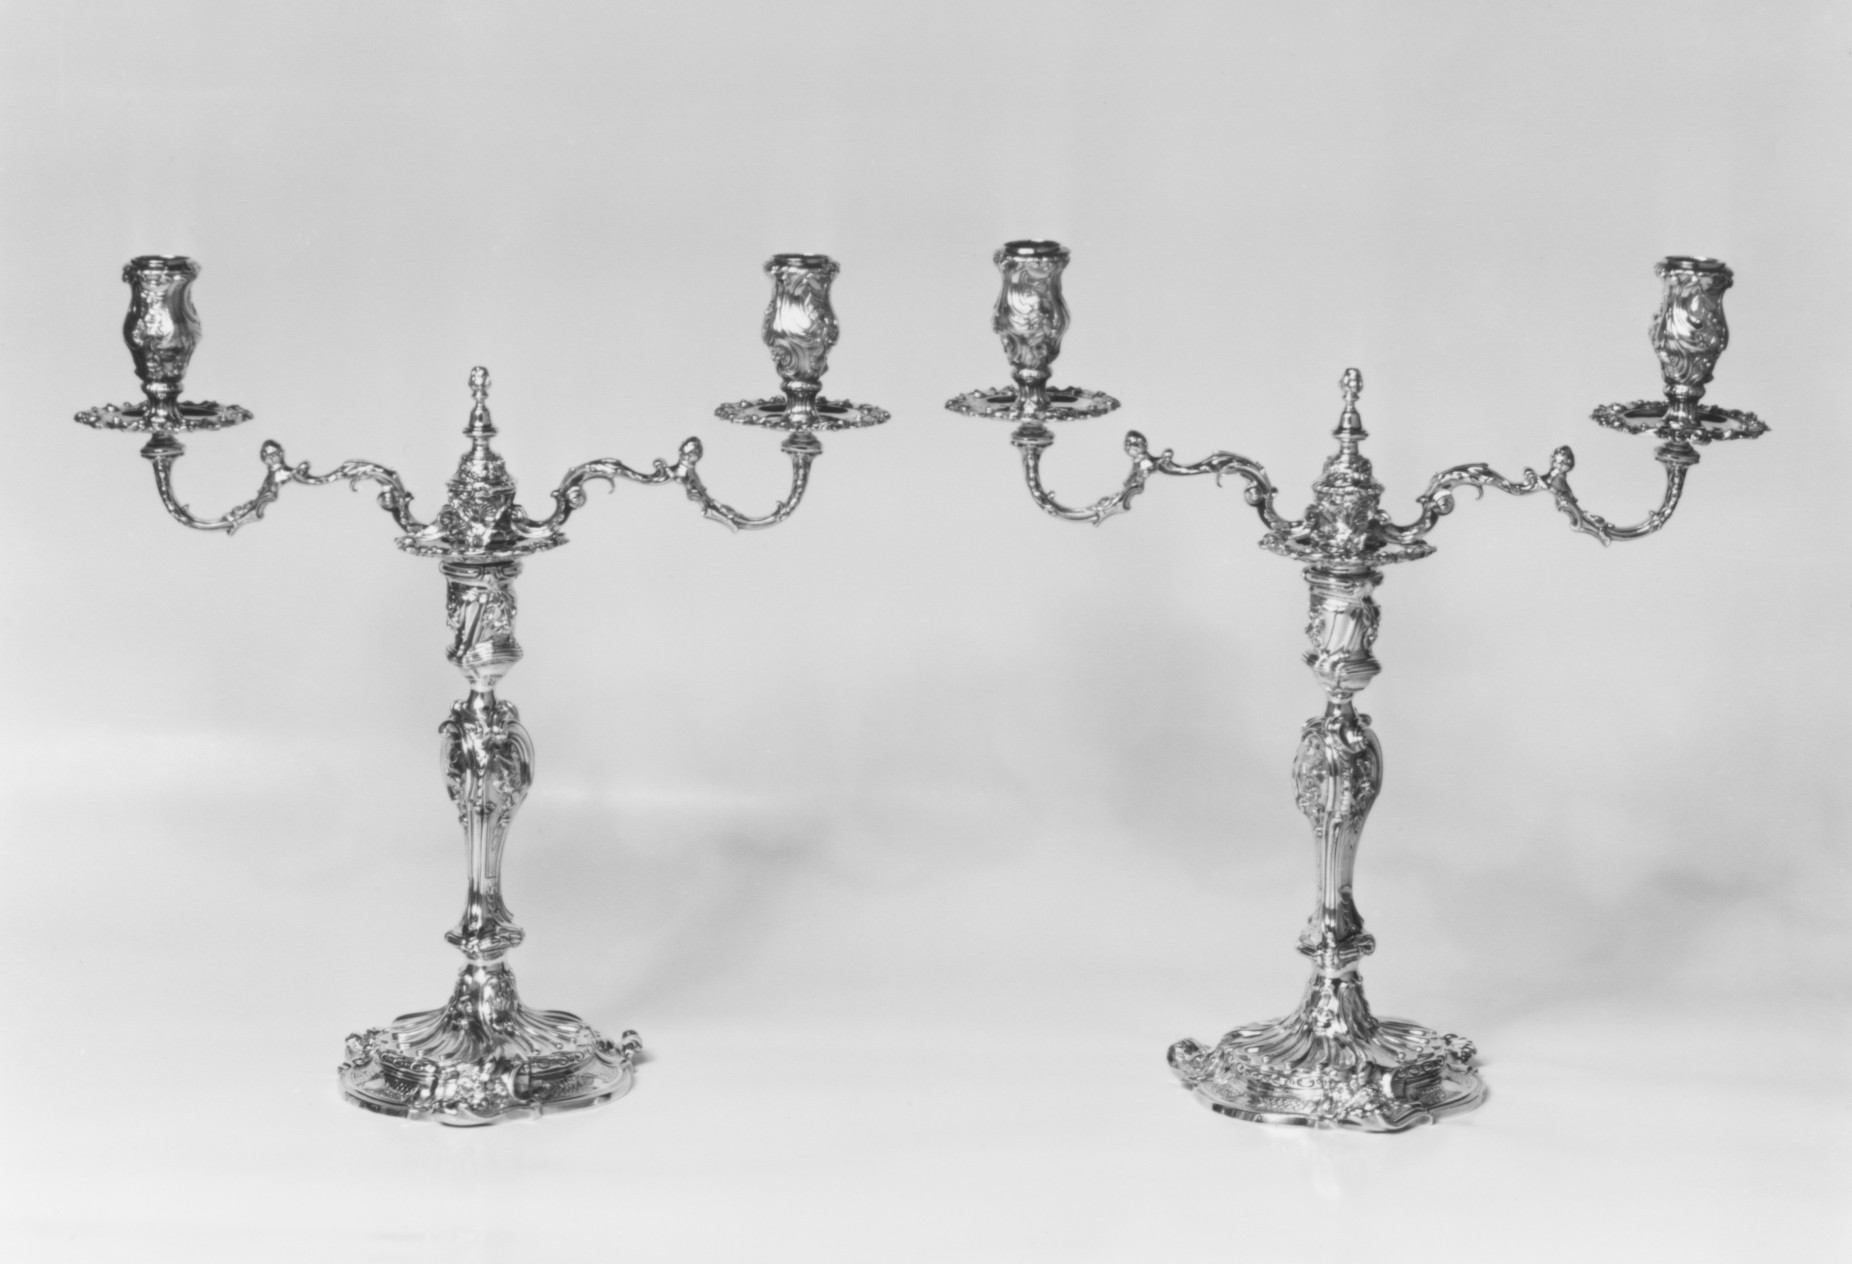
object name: candlestick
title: Pair of candlesticks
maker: paul de lamerie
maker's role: maker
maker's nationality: british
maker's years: 1688-1751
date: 1749-1750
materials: silver